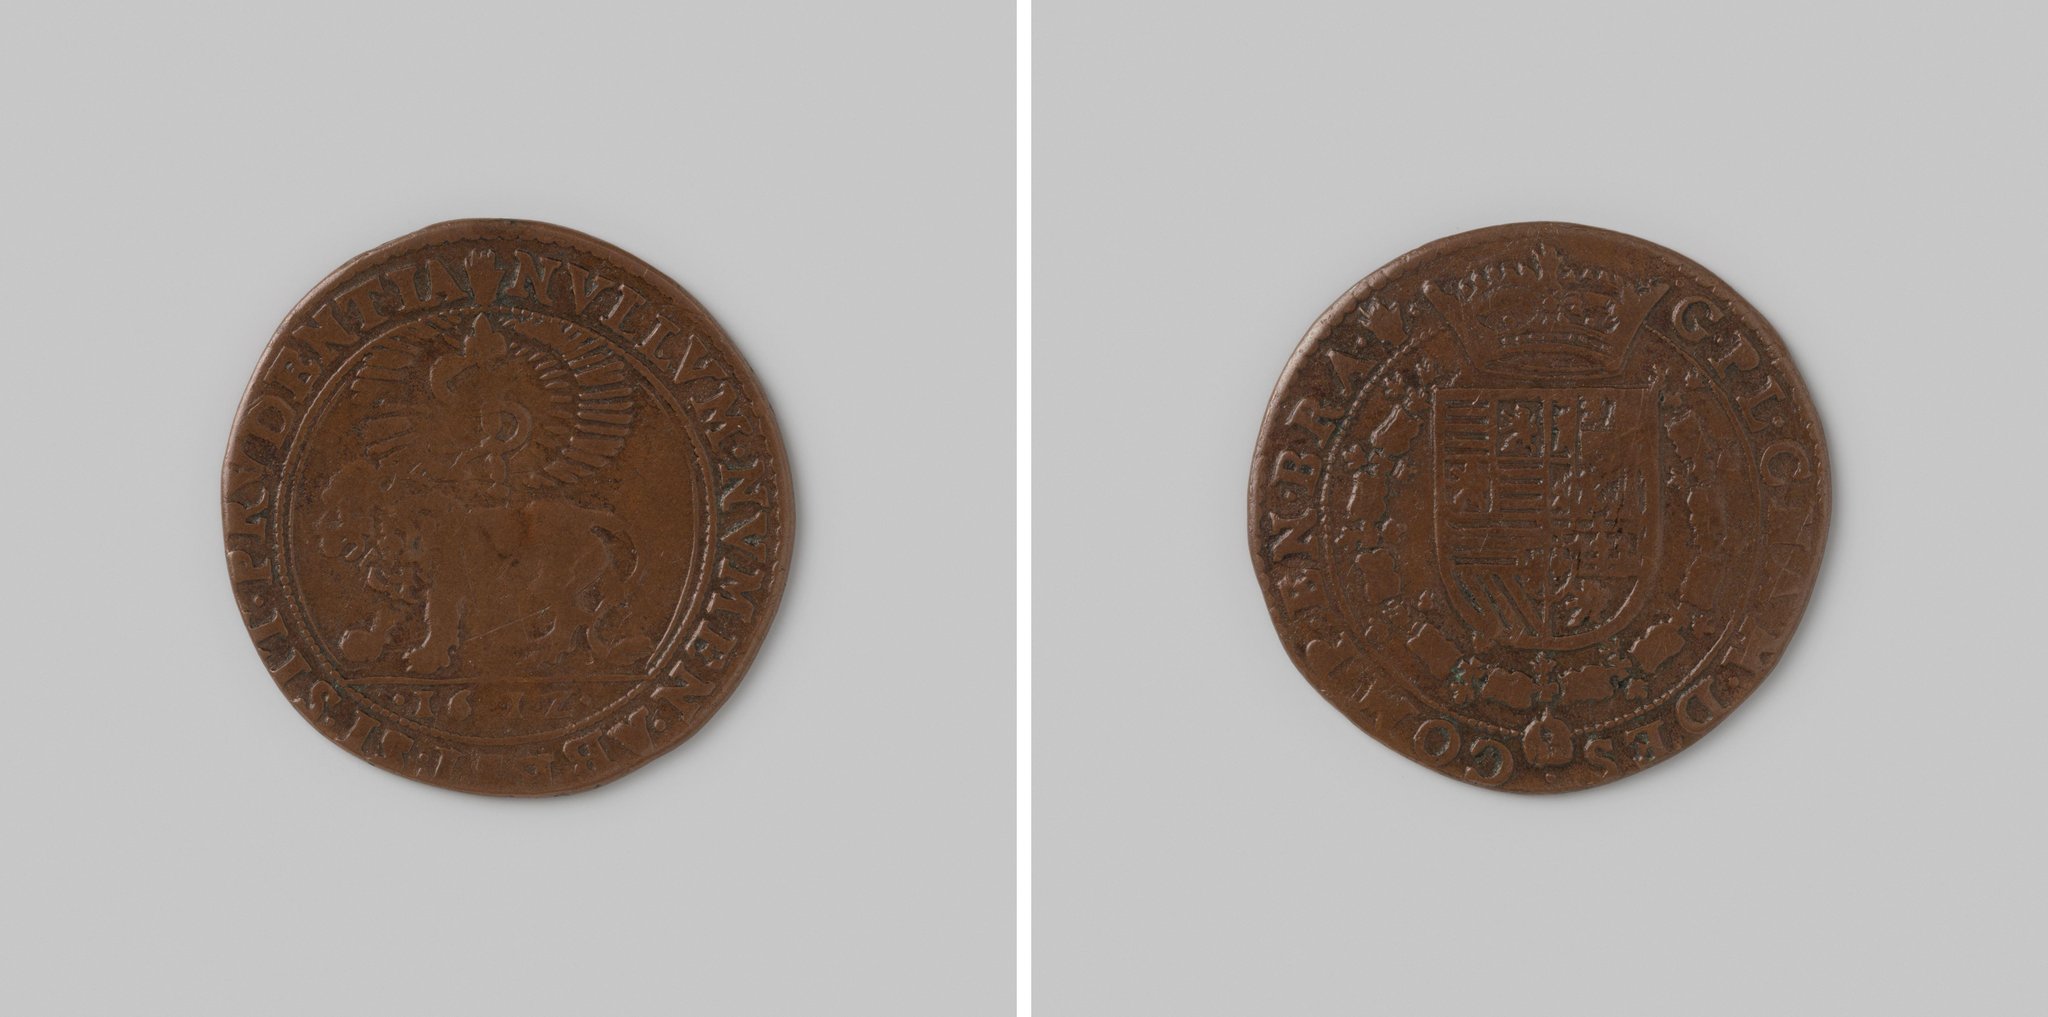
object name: jeton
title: Rekenpenning uit Antwerpen op de rechtspleging door aartshertog Albrecht in naam van de keizer 1612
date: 1612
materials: copper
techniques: striking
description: Koperen penning, op de voorzijde een leeuw lopend naar links waarachter een stralende slangenstaf, met omschrift, op de keerzijde het gekroonde Spaanse wapenschild omhangen met de keten van het Gulden Vlies, met omschrift.